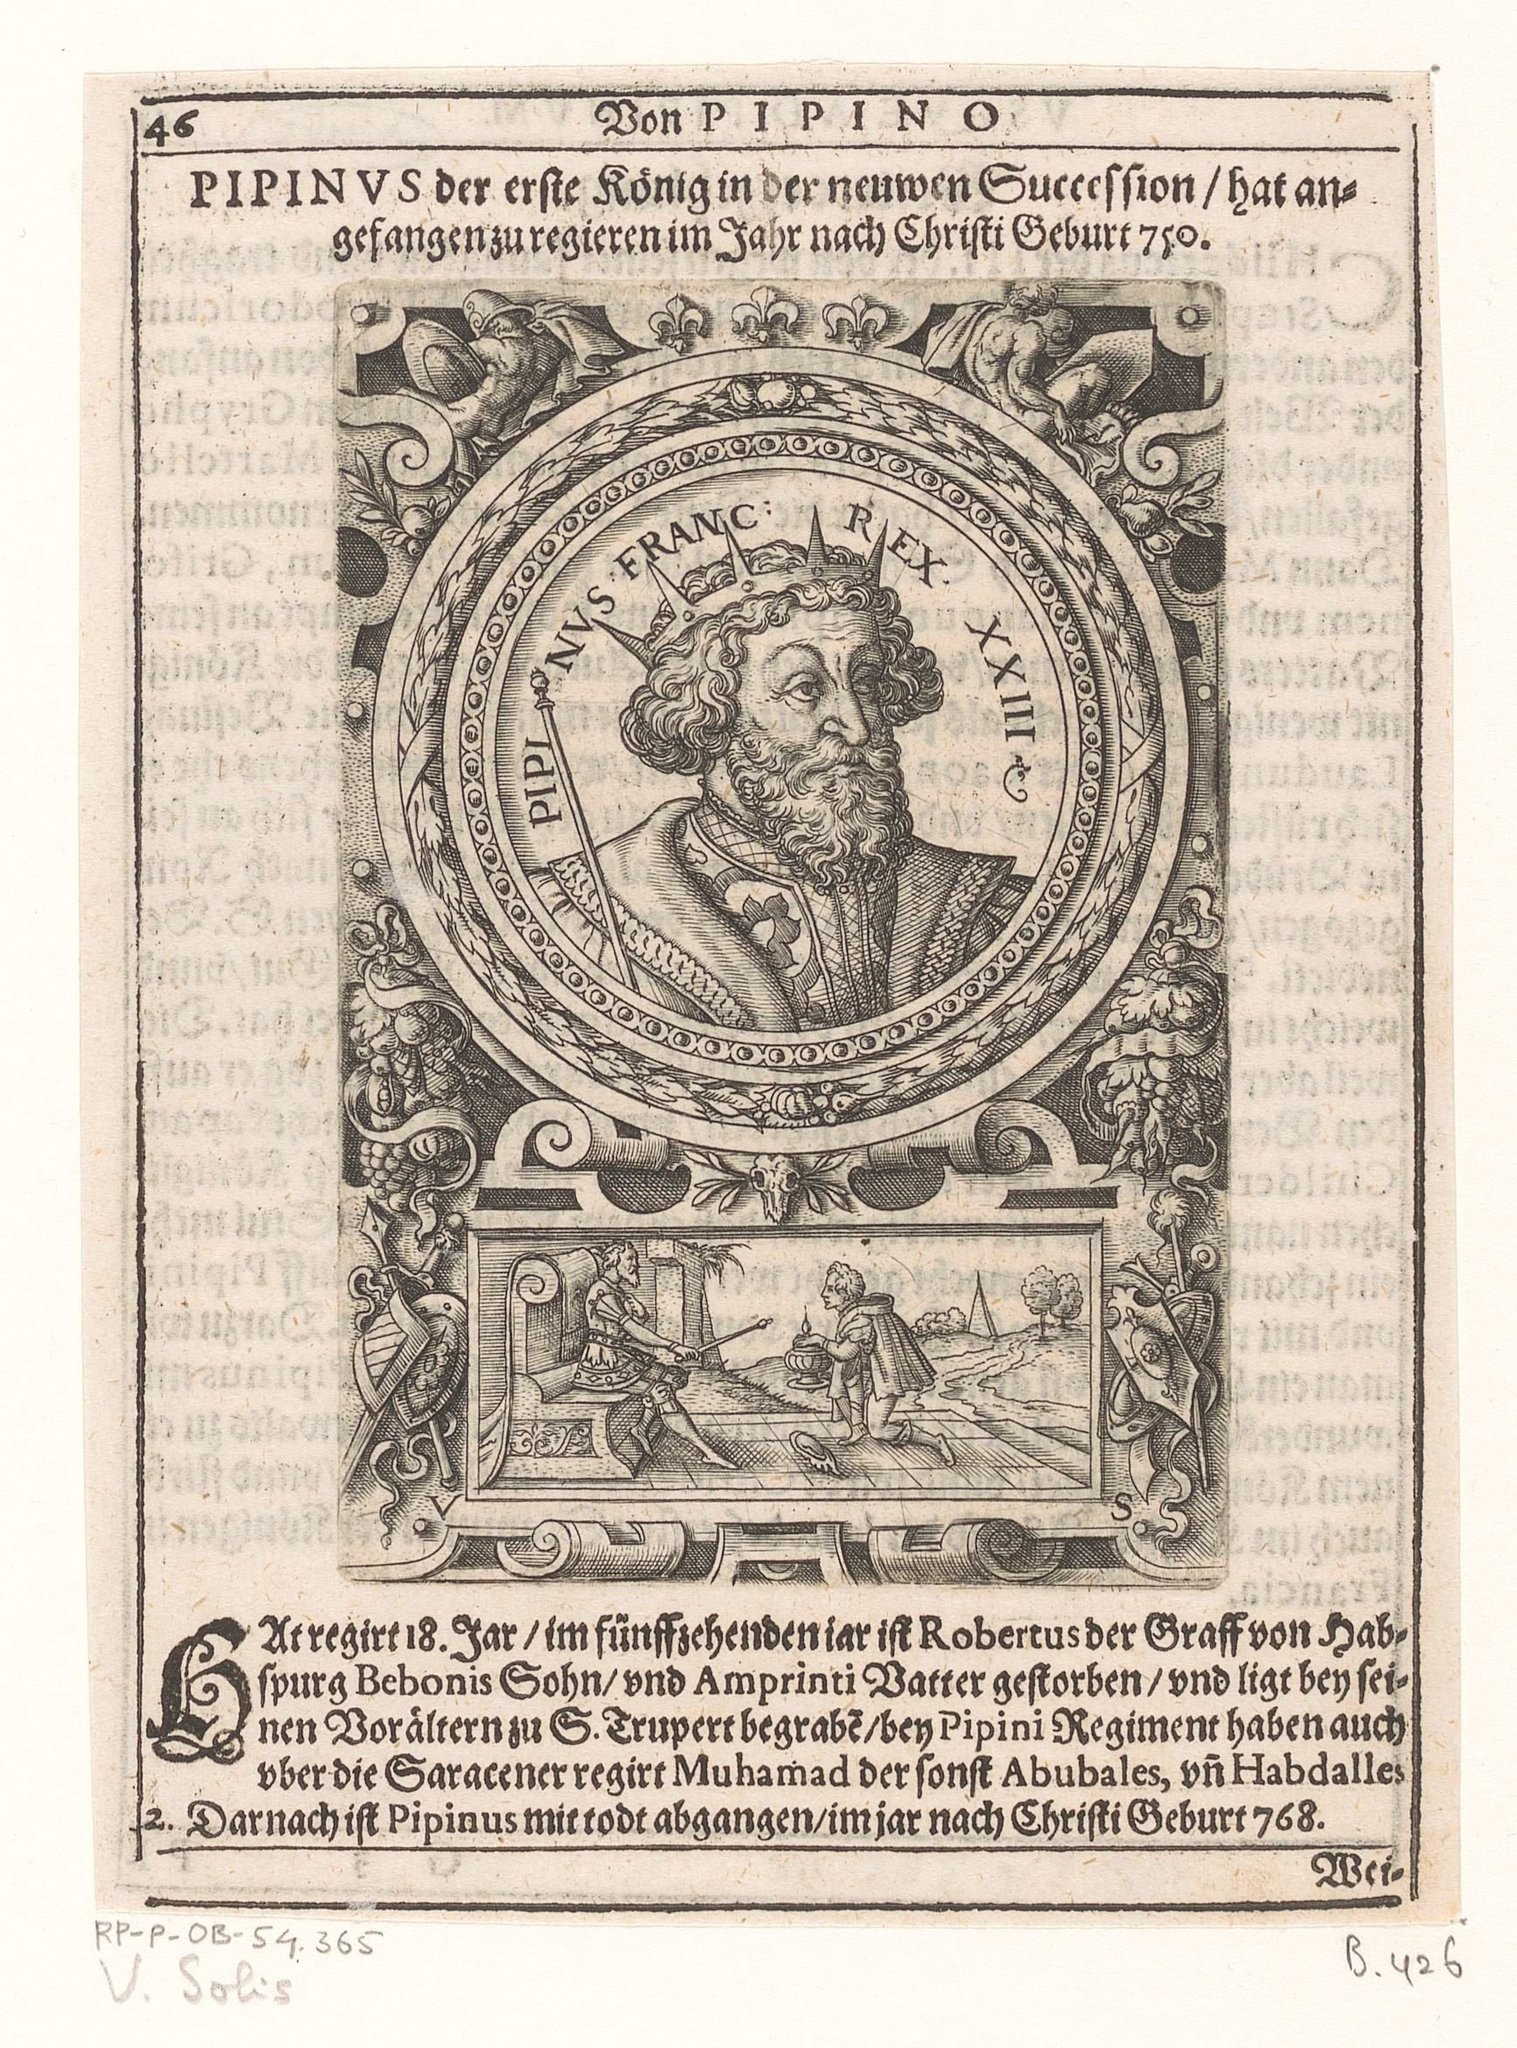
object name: print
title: Portret van Pepijn de Korte, koning der Franken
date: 1598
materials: paper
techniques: engraving, etching, intaglio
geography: nuremberg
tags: liège, scrollwork, strapwork ~ ornament, historical persons, ruler, sovereign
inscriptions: number: ‘158’, collector's mark: Lugt 2228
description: Prent afkomstig uit de publicatie: Michael Eizinger. Könige in Frankreich. Keulen: Johann Bussemacher, 1598, p. 46. De publicatie bevat prenten van Jost Amman en Virgil Solis.